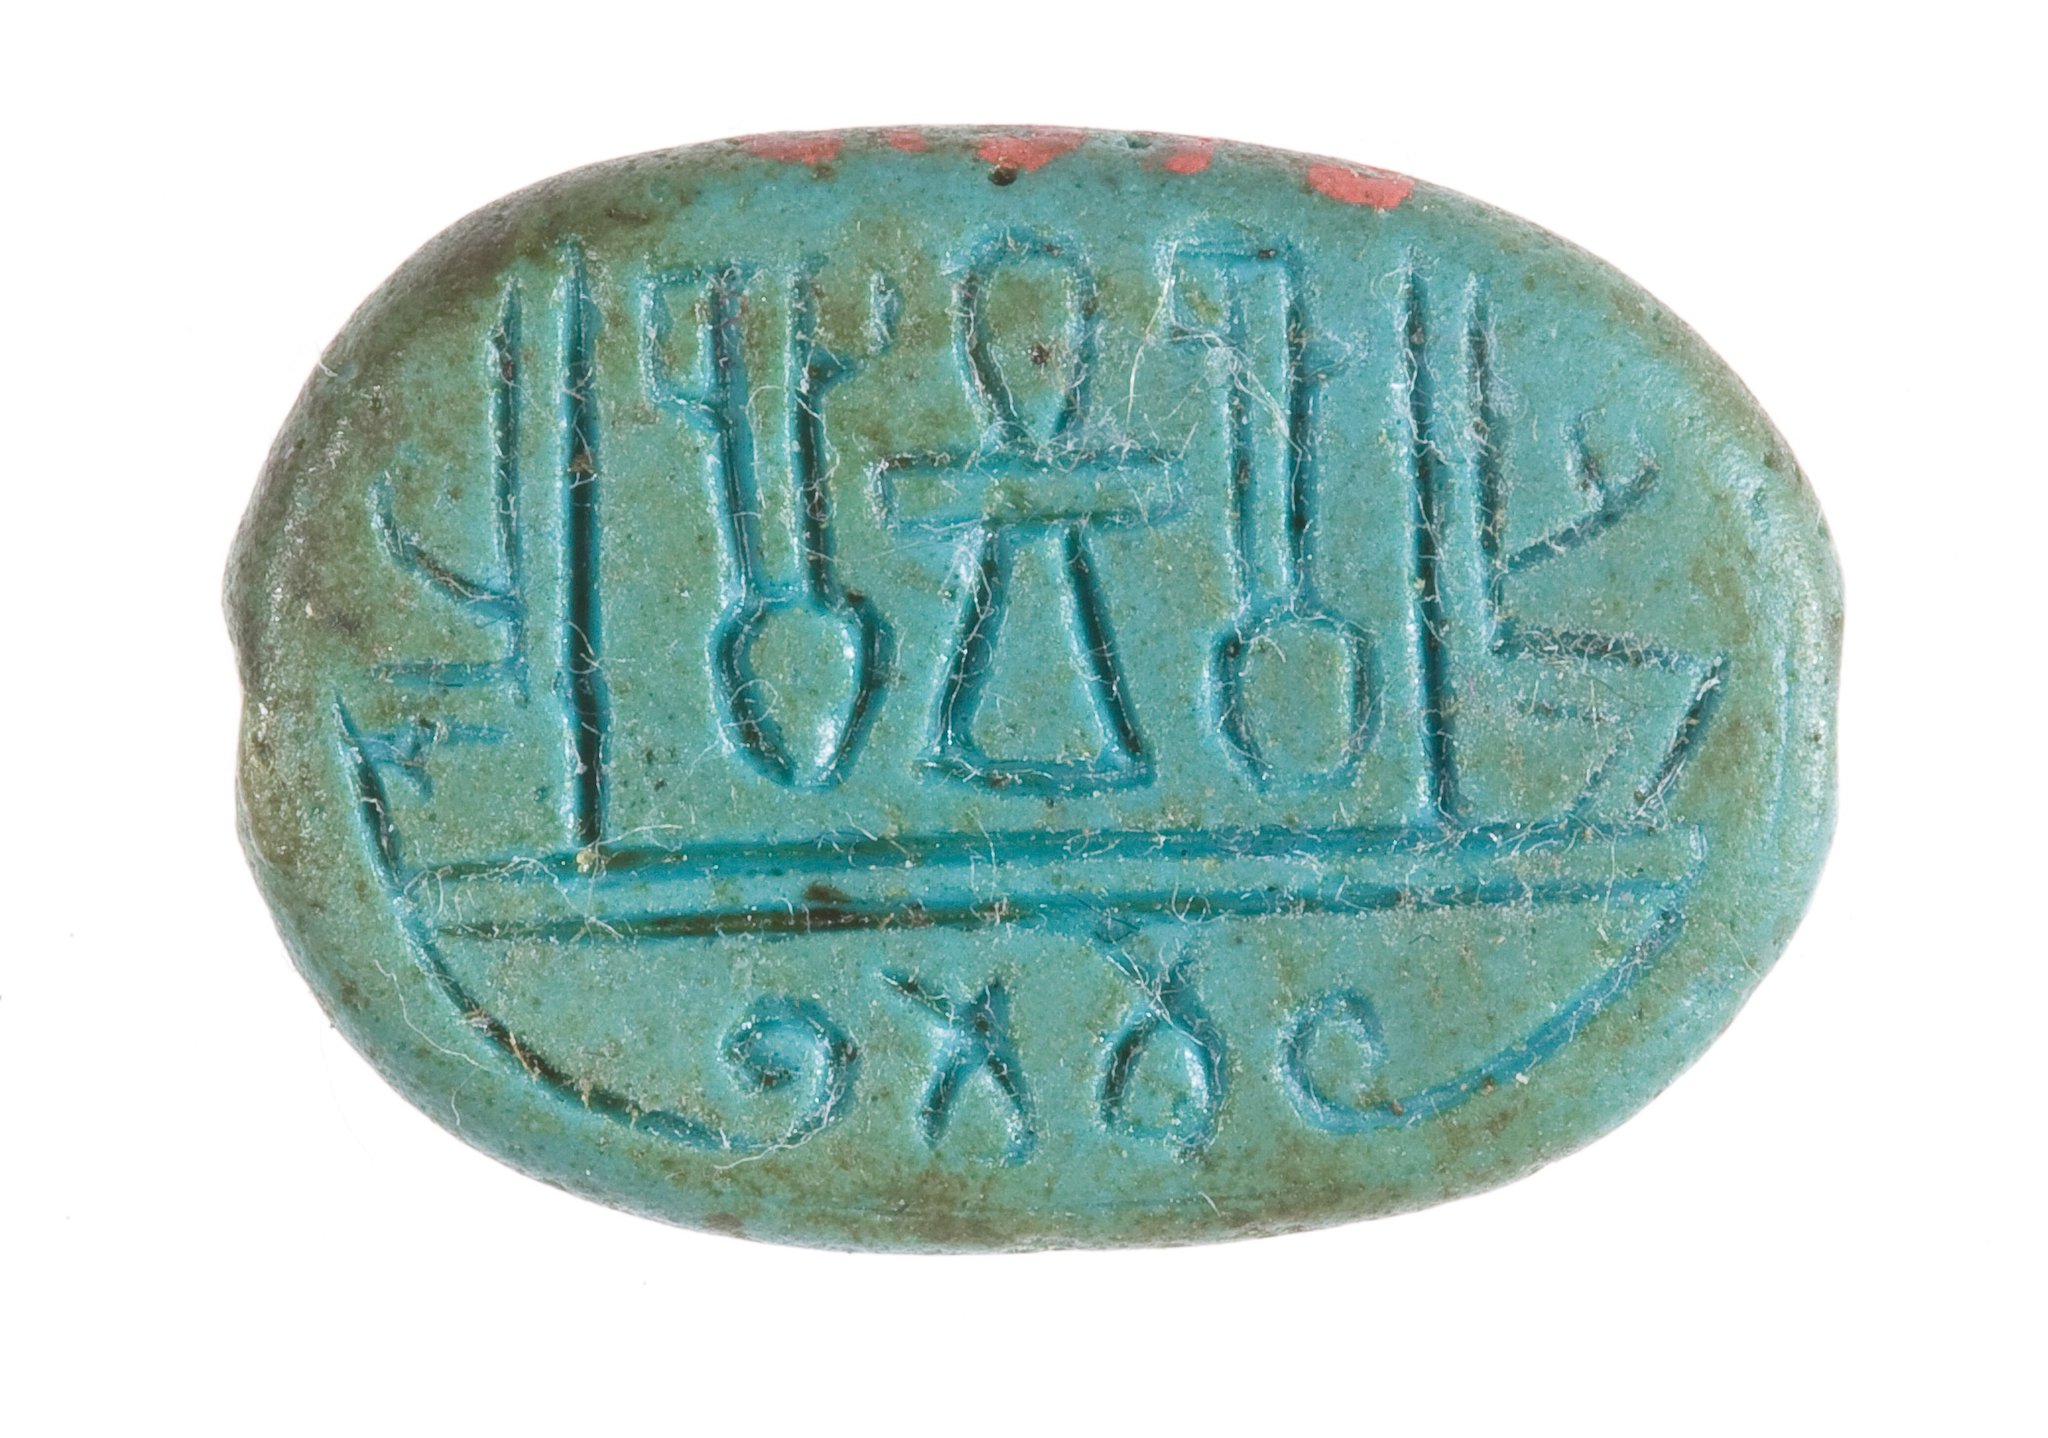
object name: scarab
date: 1991-1450 BCE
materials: stone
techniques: glazing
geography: egypt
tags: hieroglyphs,scarabs